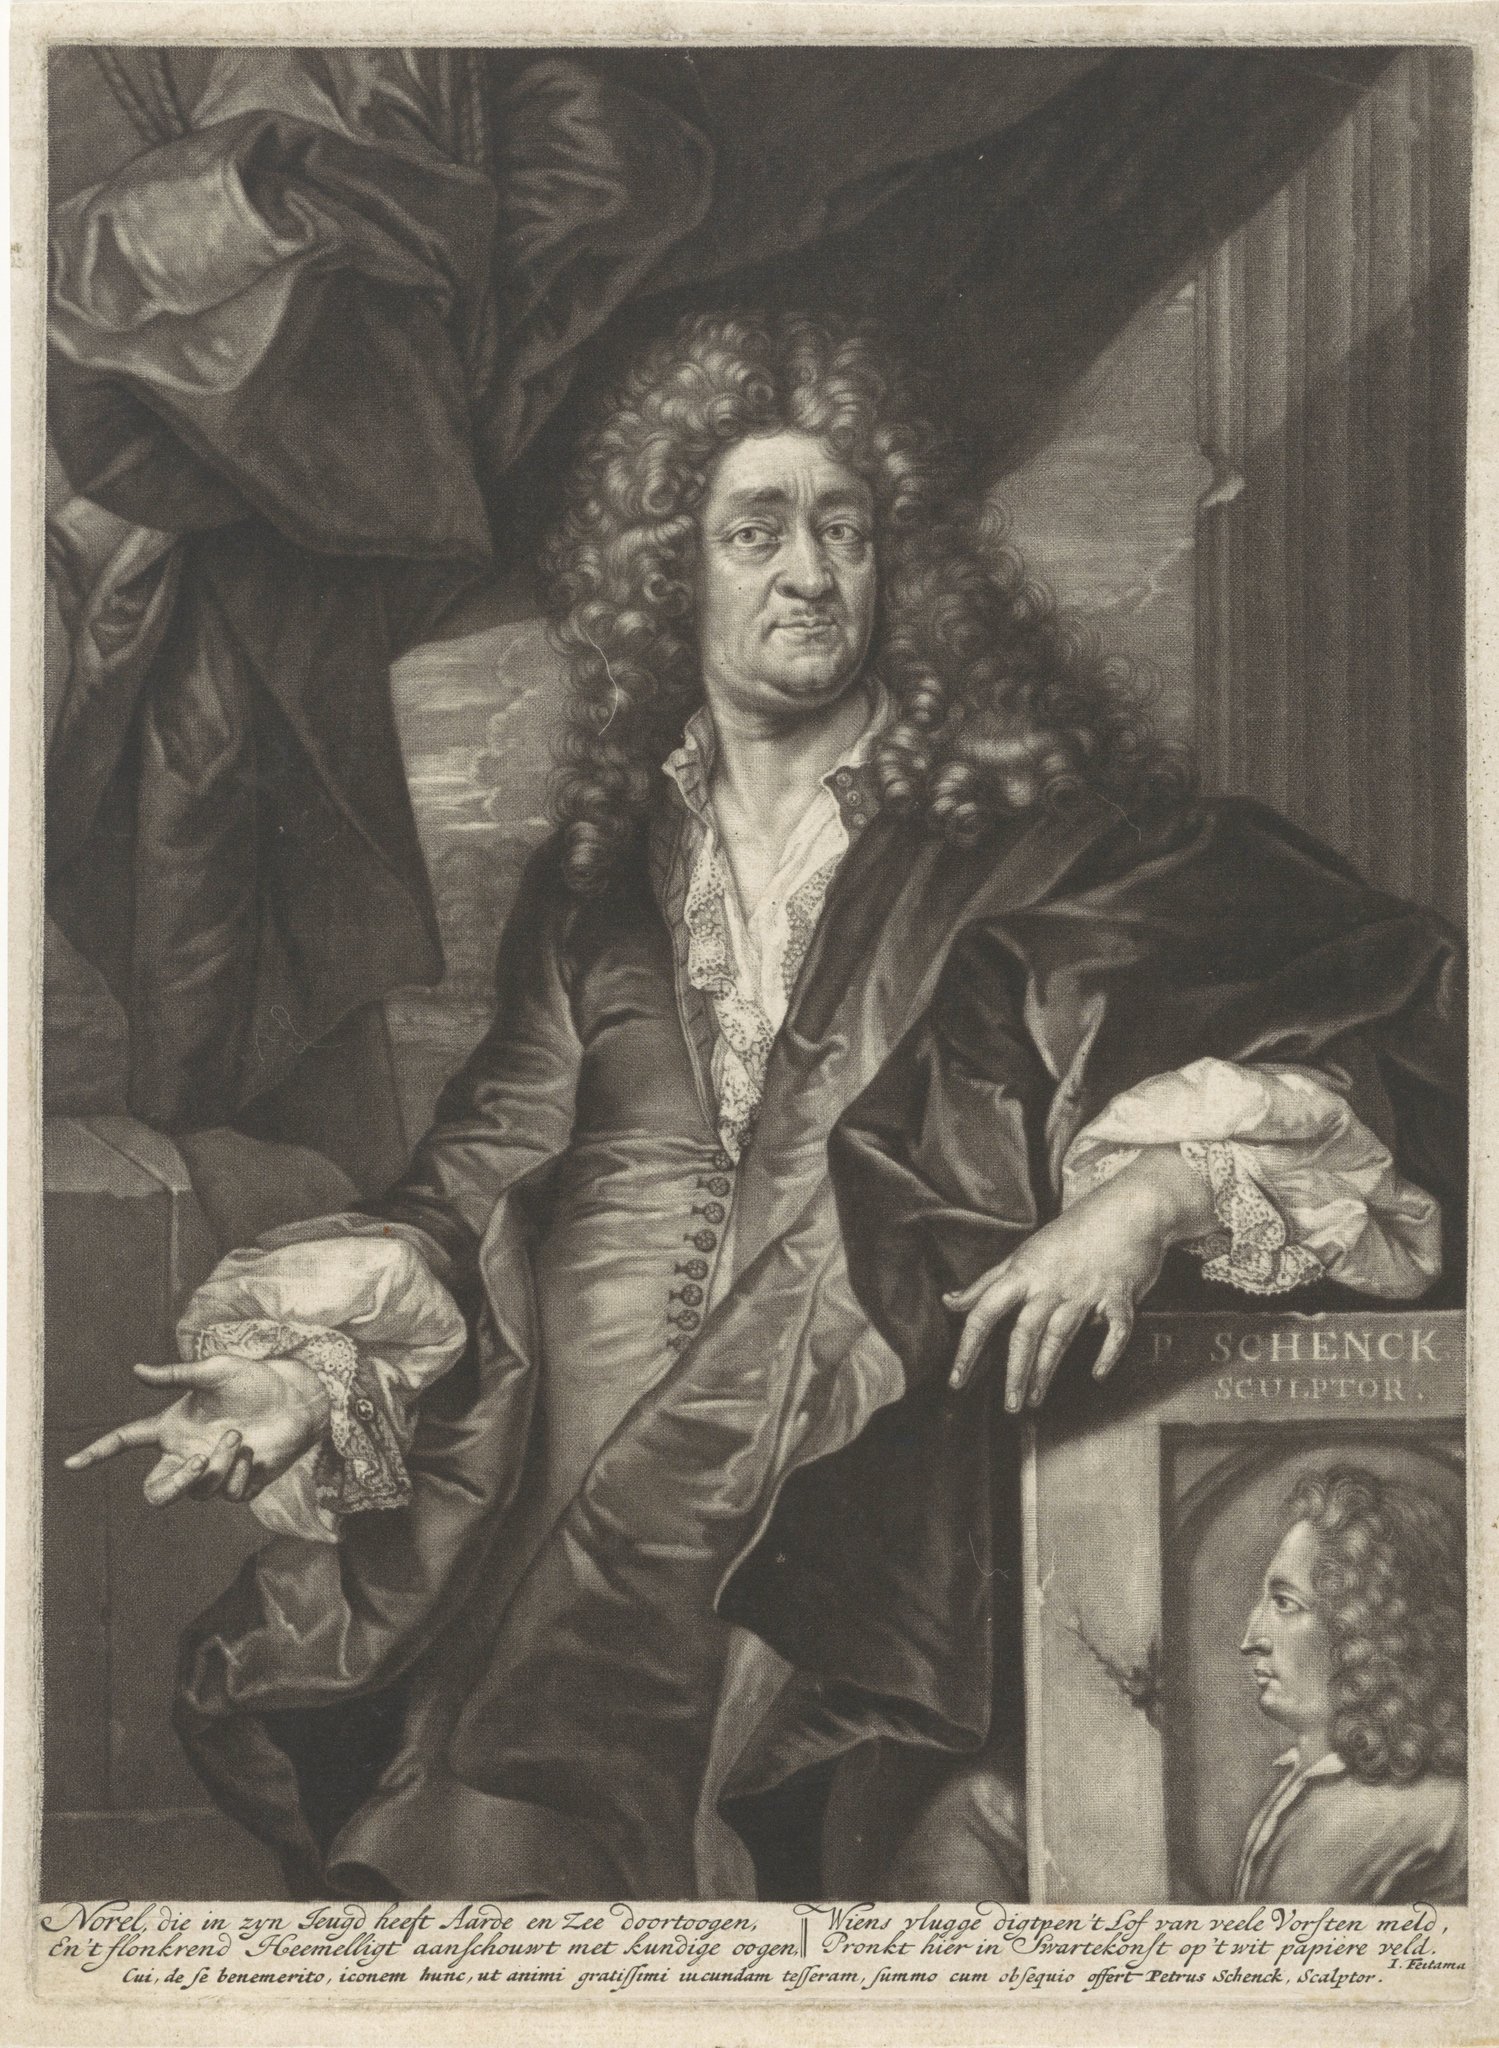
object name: print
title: Portret van Jan Norel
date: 1670-1713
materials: paper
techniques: engraving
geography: amsterdam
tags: jan norel, portrait of a writer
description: De dichter Jan Norel staat naast een plaquette waarop een portret in profiel. In de marge een lofdicht op de reislustigheid en de dichtkunst van de geportretteerde.